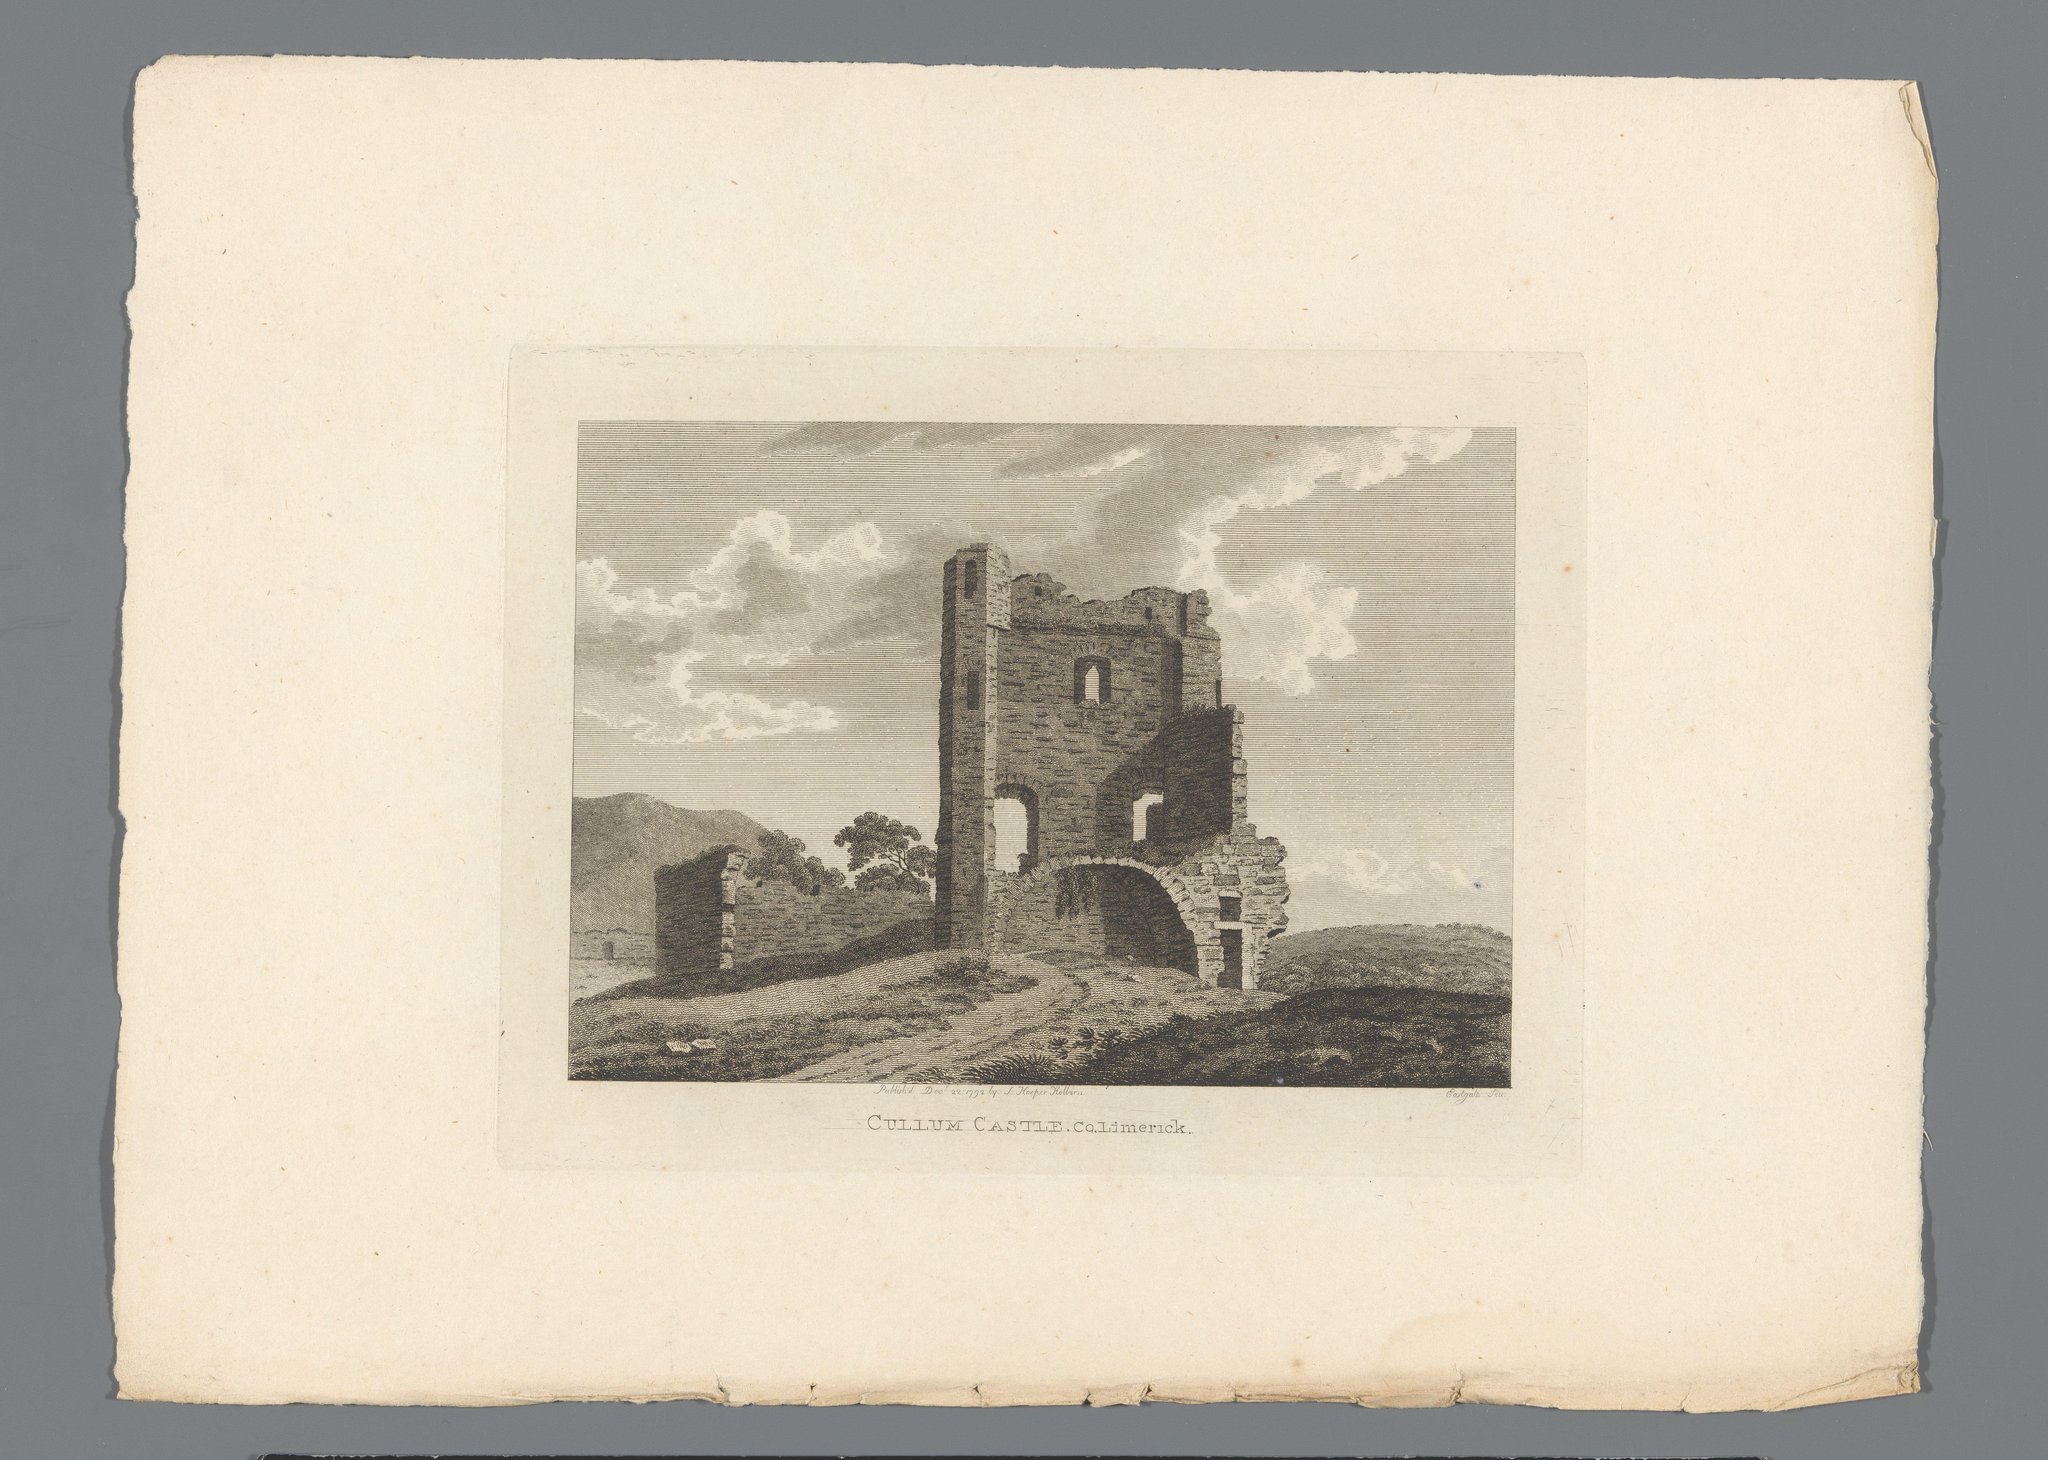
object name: print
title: Gezicht op de ruïnes van Cullum Castle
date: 1792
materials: paper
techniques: etching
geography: london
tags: landscape with ruins, landscape with tower or castle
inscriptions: date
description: Prent verschenen in: Grose, Francis. The antiquities of Ireland. Londen: S. Hooper, 1795, dl. 2.